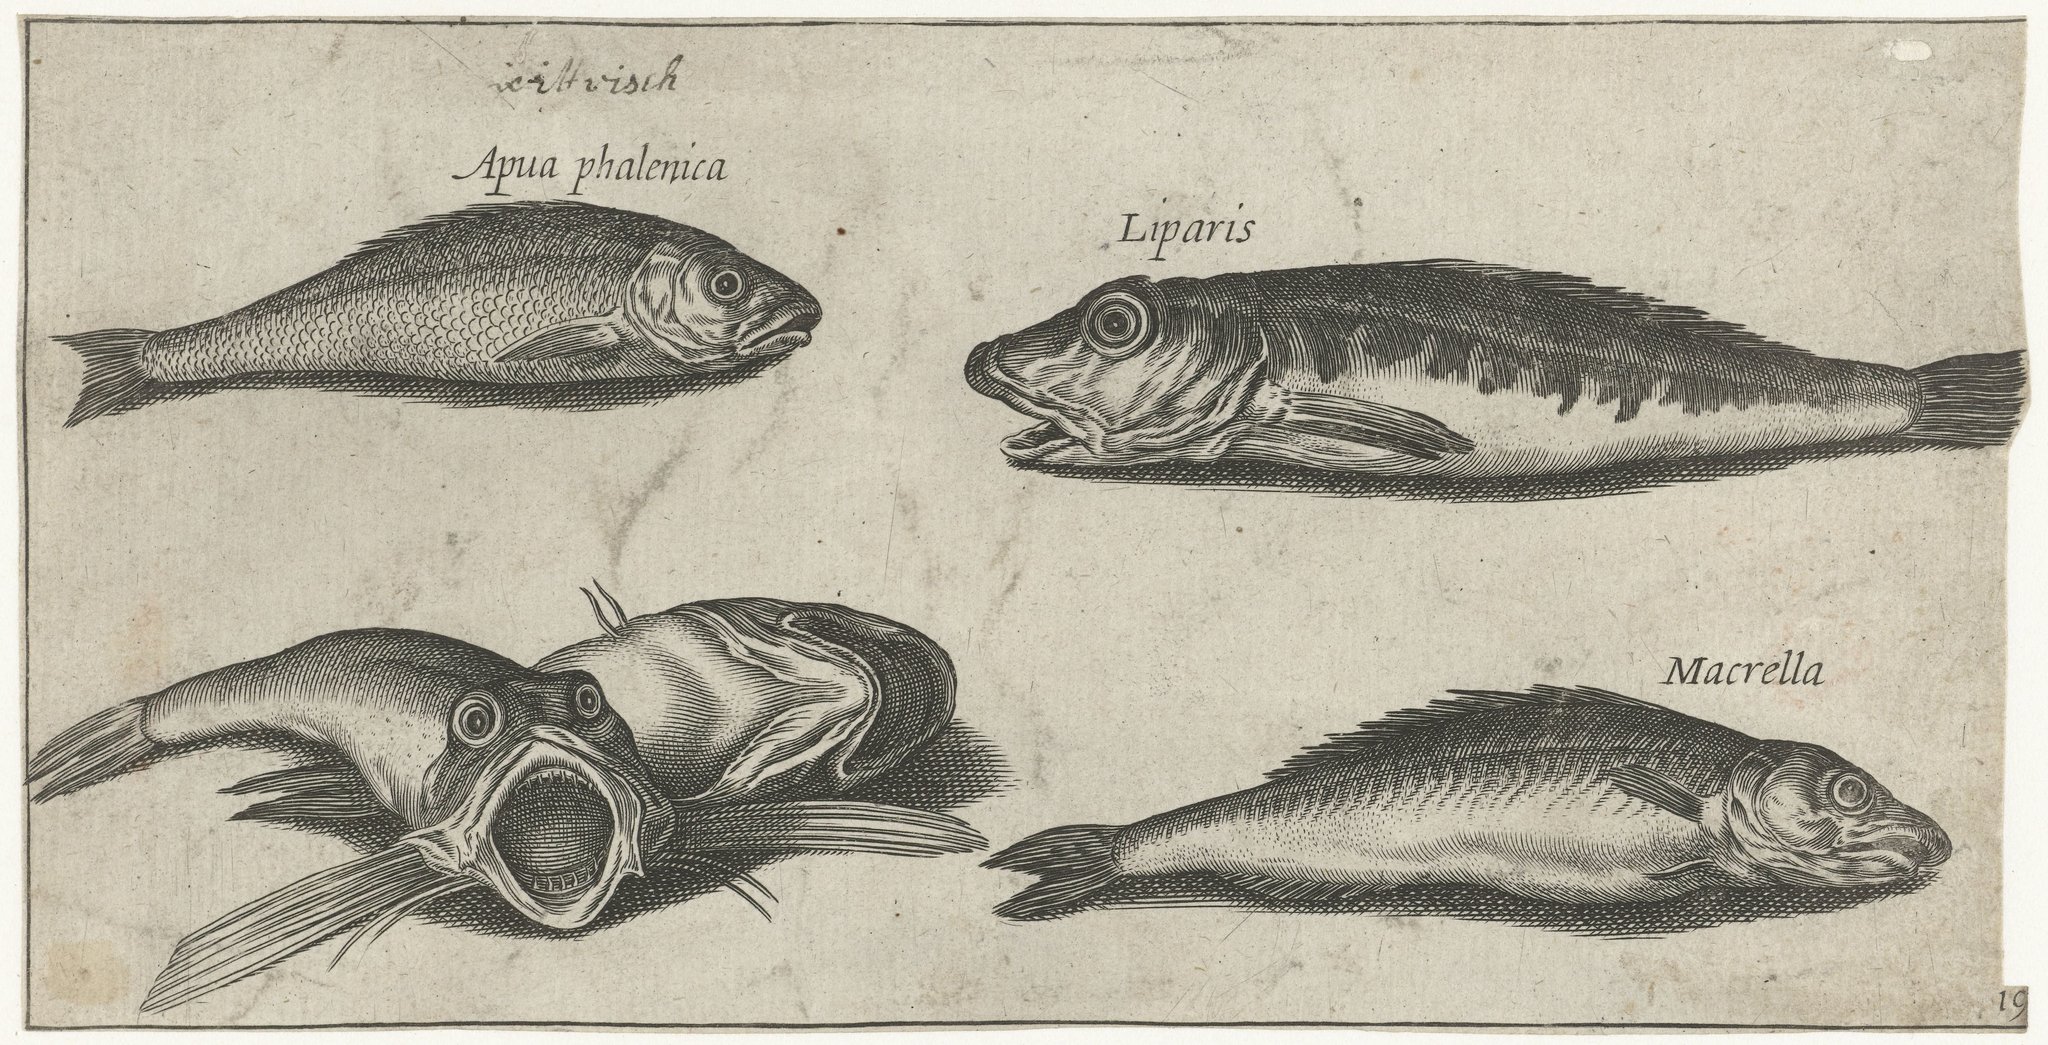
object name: print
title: Brasem, makreel, twee ponen en een snotolf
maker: pierre firens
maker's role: print maker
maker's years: 1580-1638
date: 1600-1638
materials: paper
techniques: engraving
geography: paris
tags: fishes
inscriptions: collector's mark: Lugt 2228